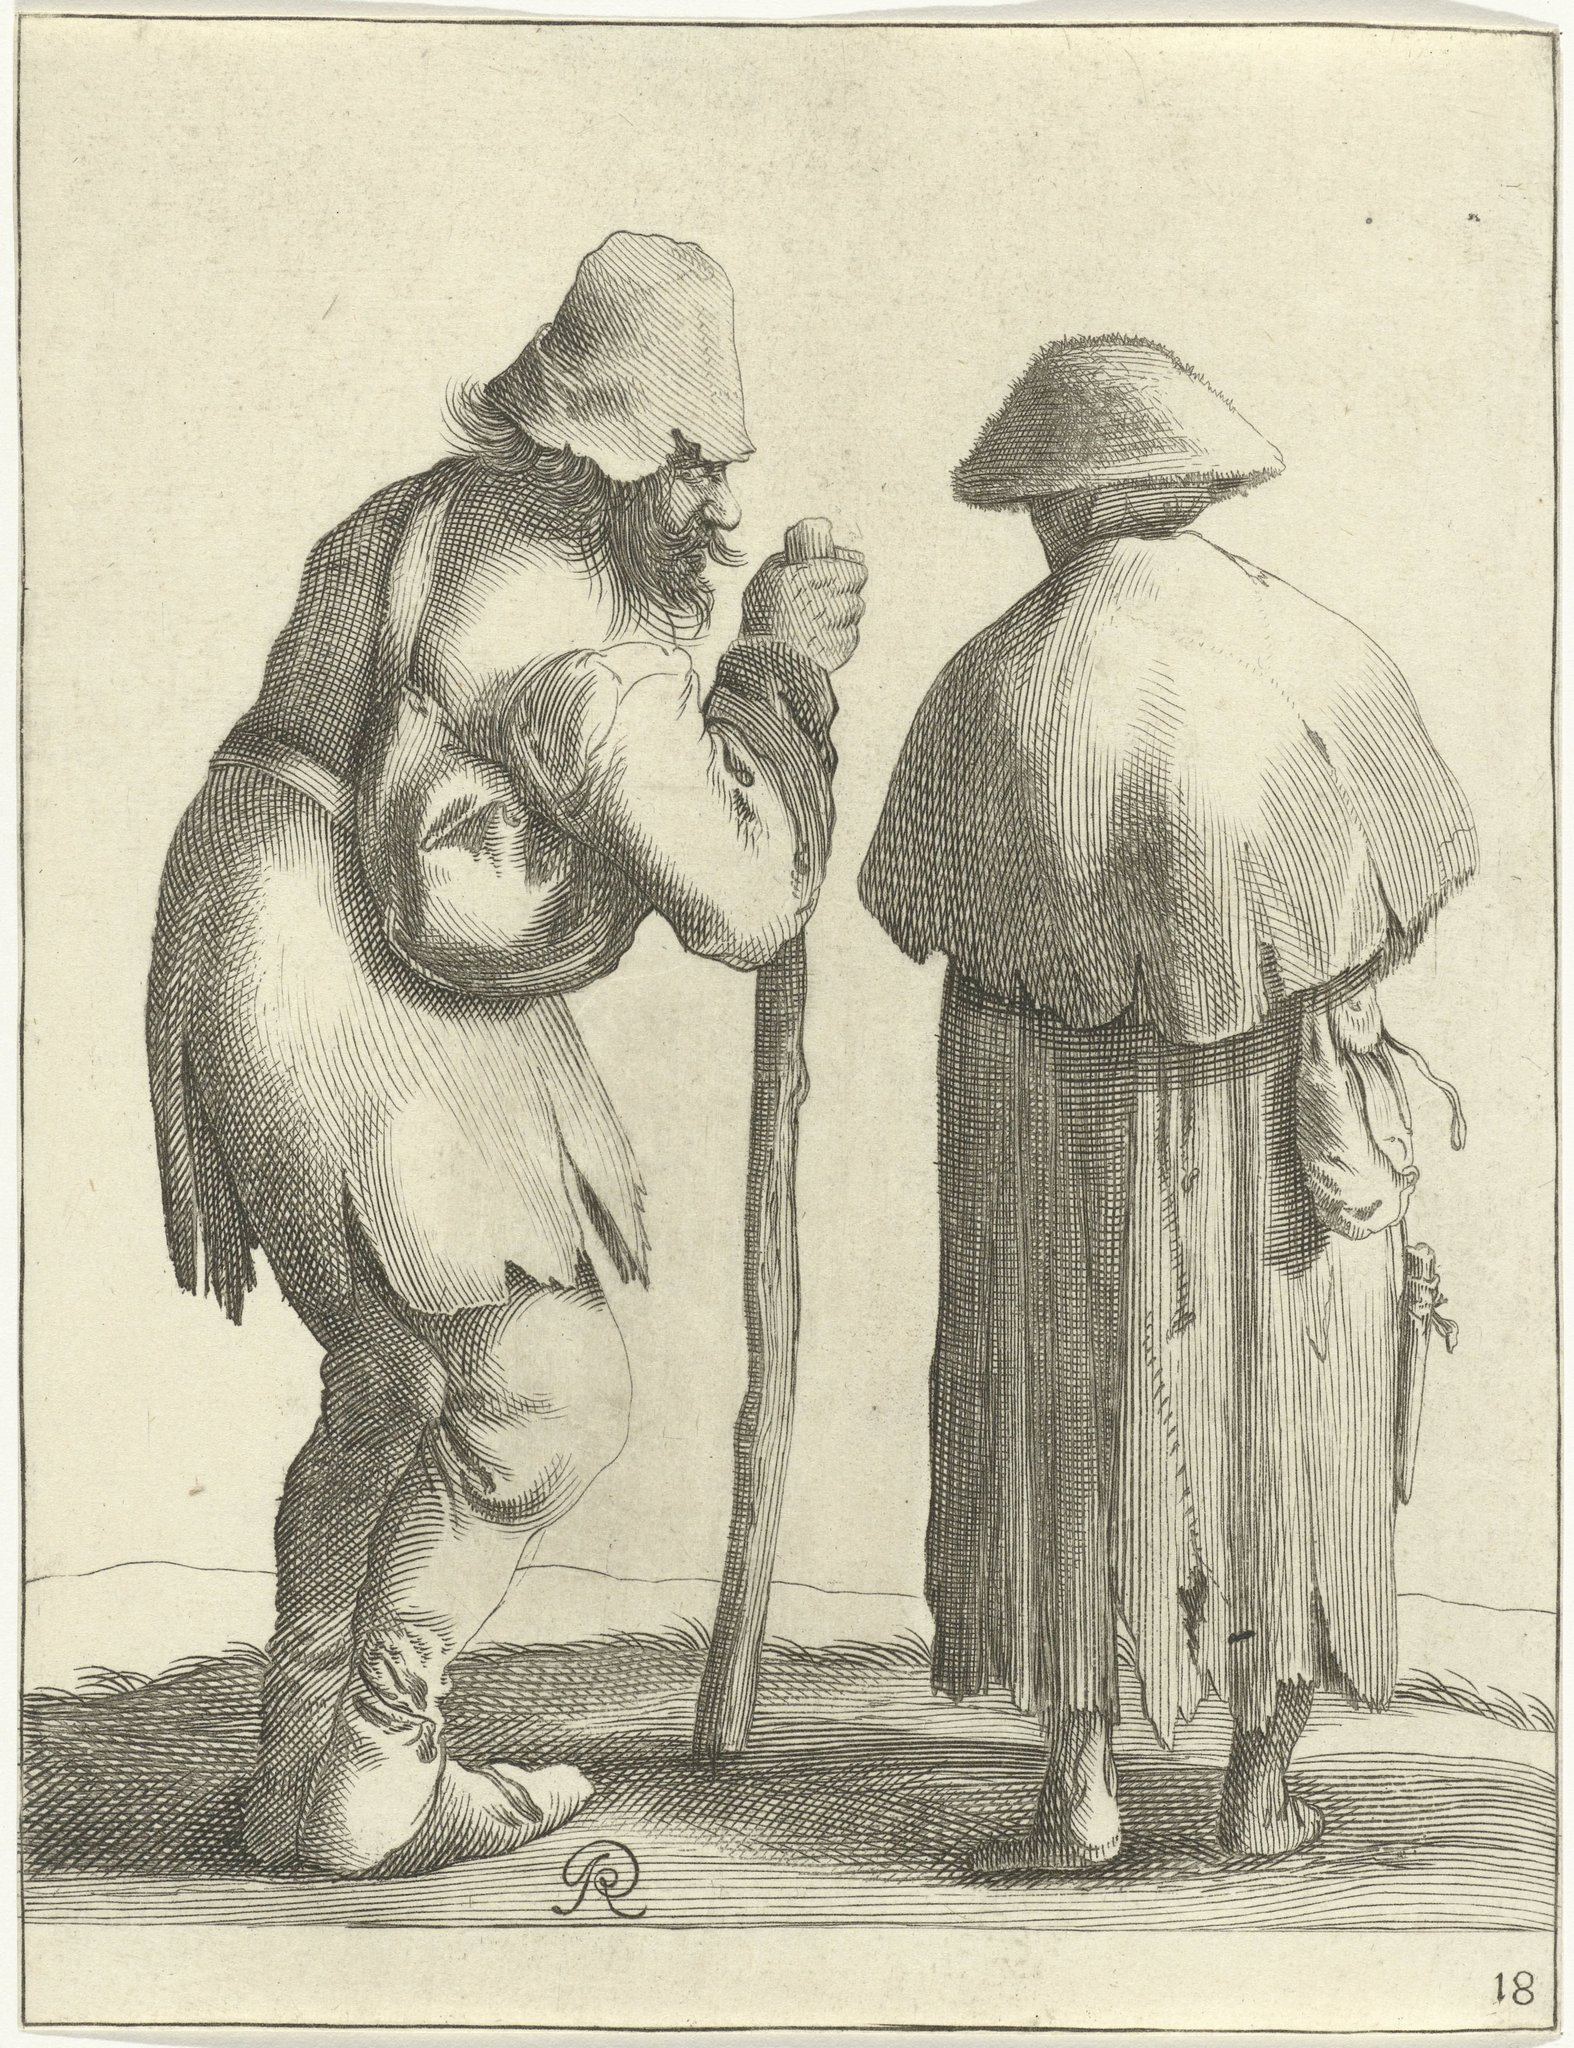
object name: print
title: Bedelaarspaar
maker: pieter jansz quast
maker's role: draughtsman, painter, print maker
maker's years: 1605-1647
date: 1634-1638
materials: paper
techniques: engraving, etching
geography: the hague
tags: bag, walking-stick, staff, beggar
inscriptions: collector's mark: Lugt 2228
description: Een bejaard bedelaarspaar van achteren gezien. De prent maakt deel uit van een serie van zesentwintig prenten met bedelaars en boeren.